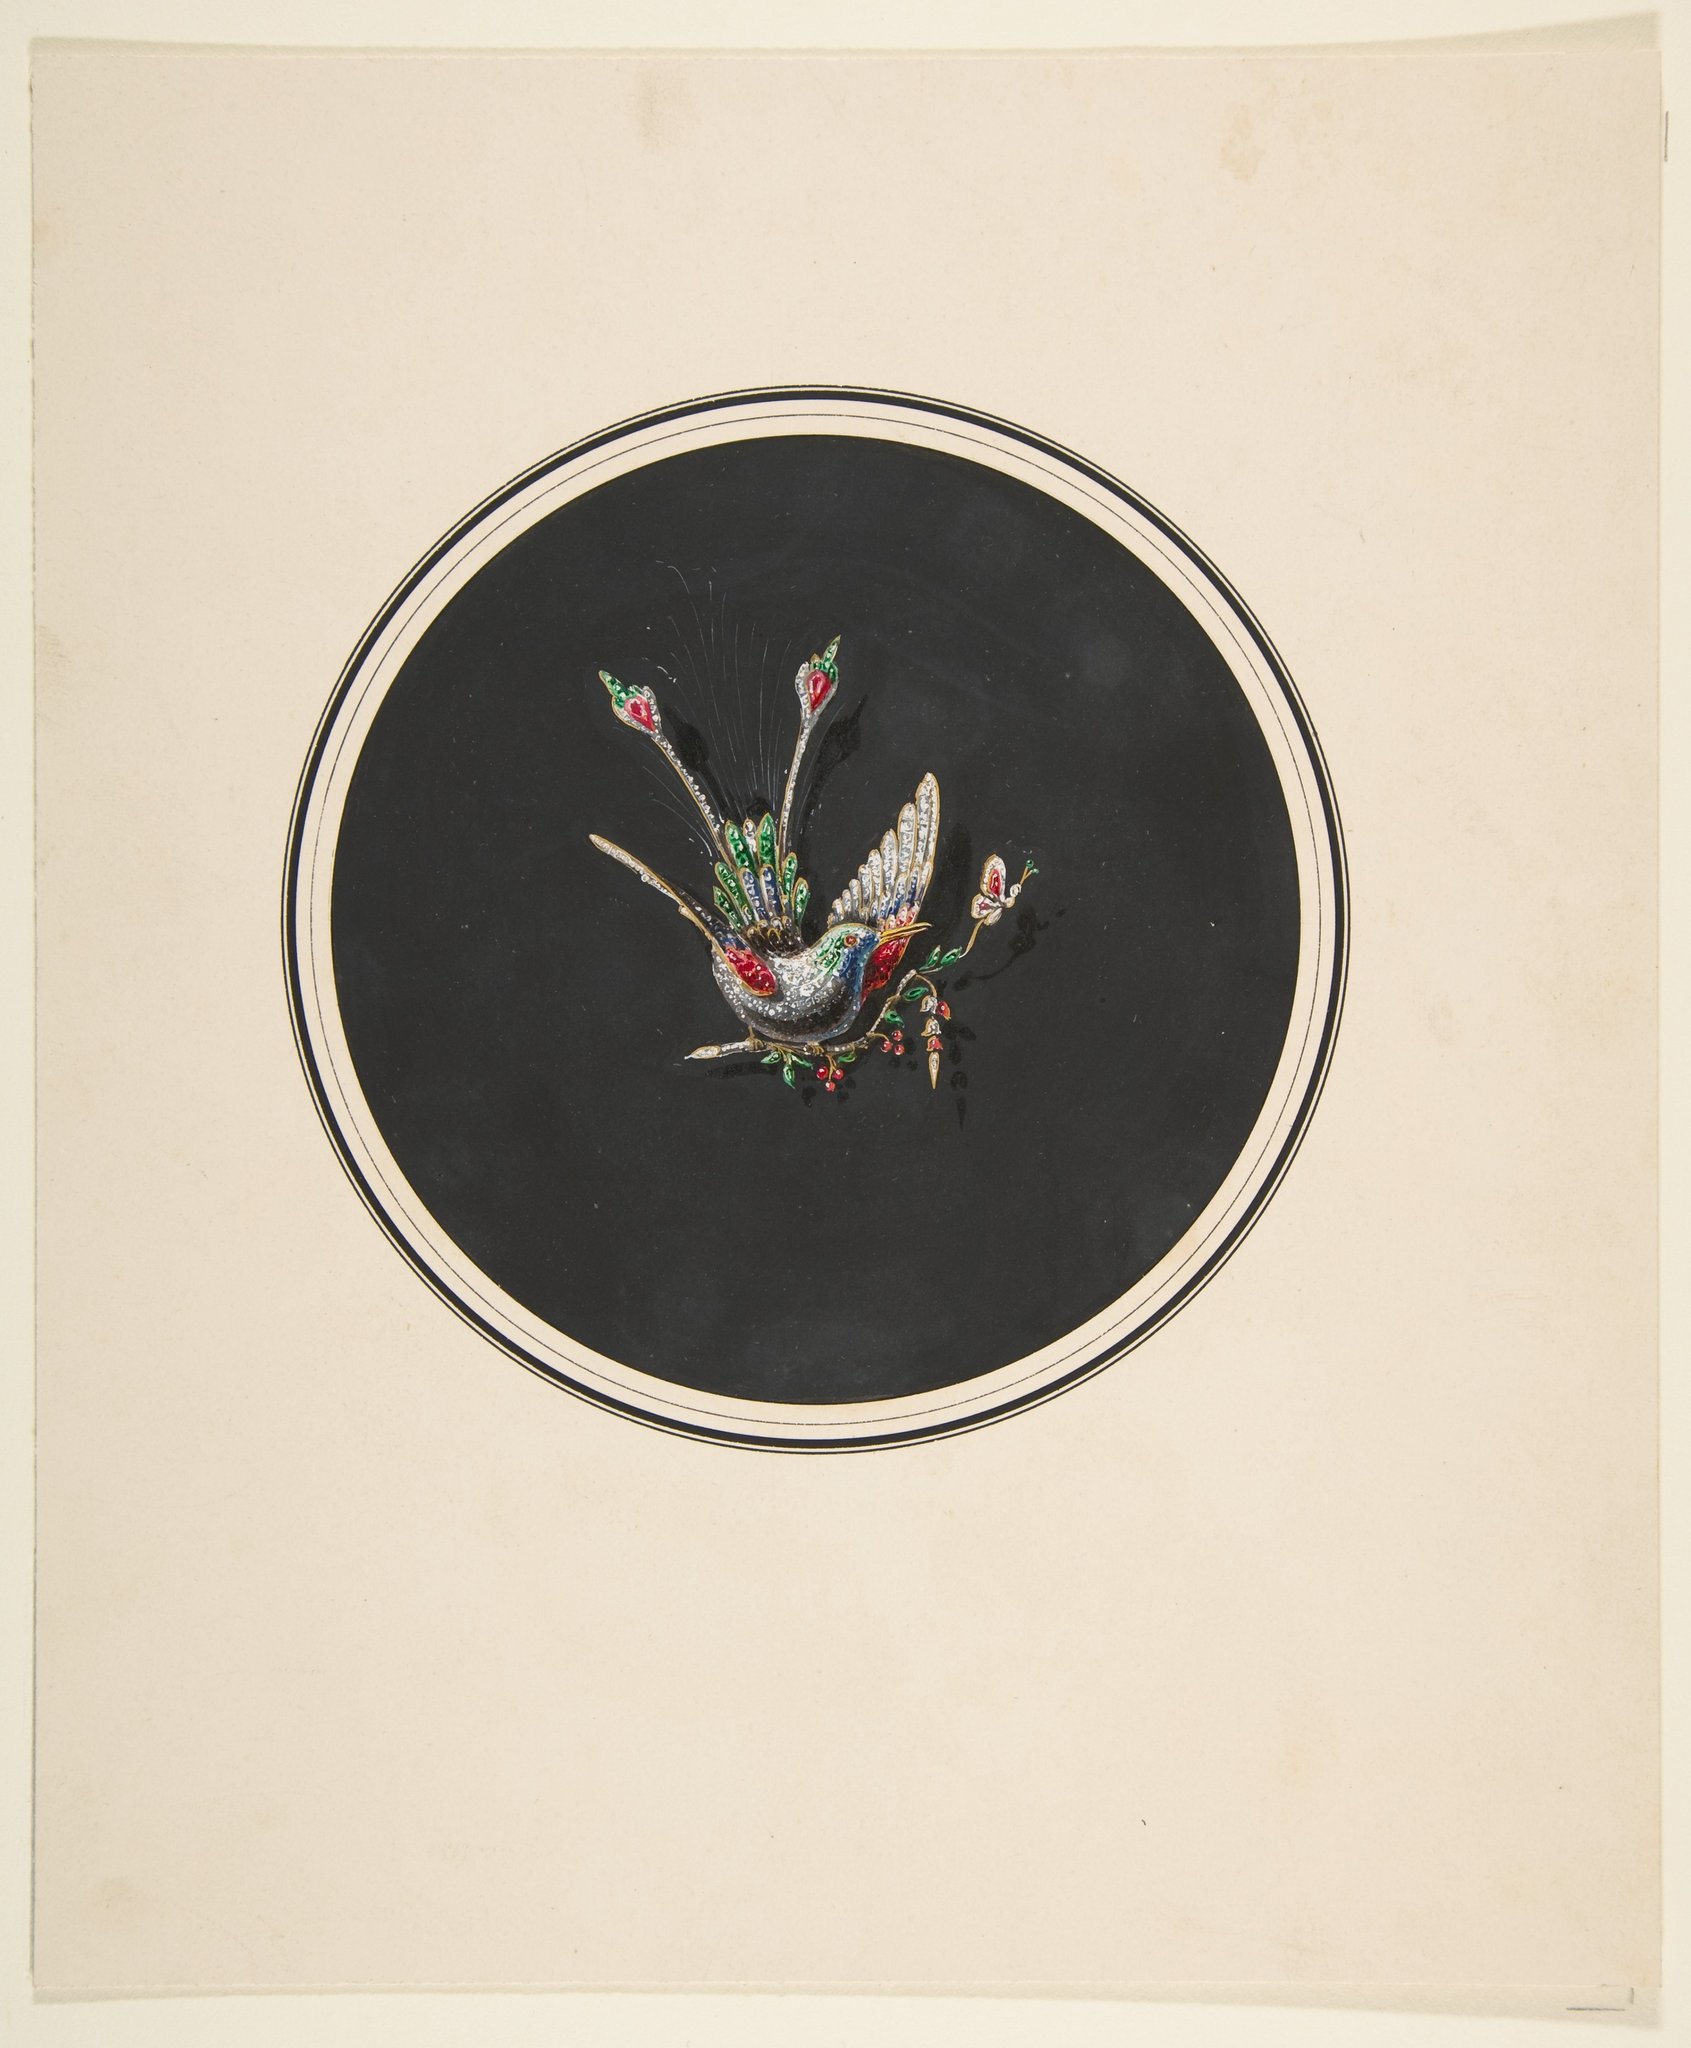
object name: drawing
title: Design for a brooch with a bird motif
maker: anonymous, french, 19th century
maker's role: artist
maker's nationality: french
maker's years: 1800-1900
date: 1801-1900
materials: cardboard, gouache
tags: birds,jewelry